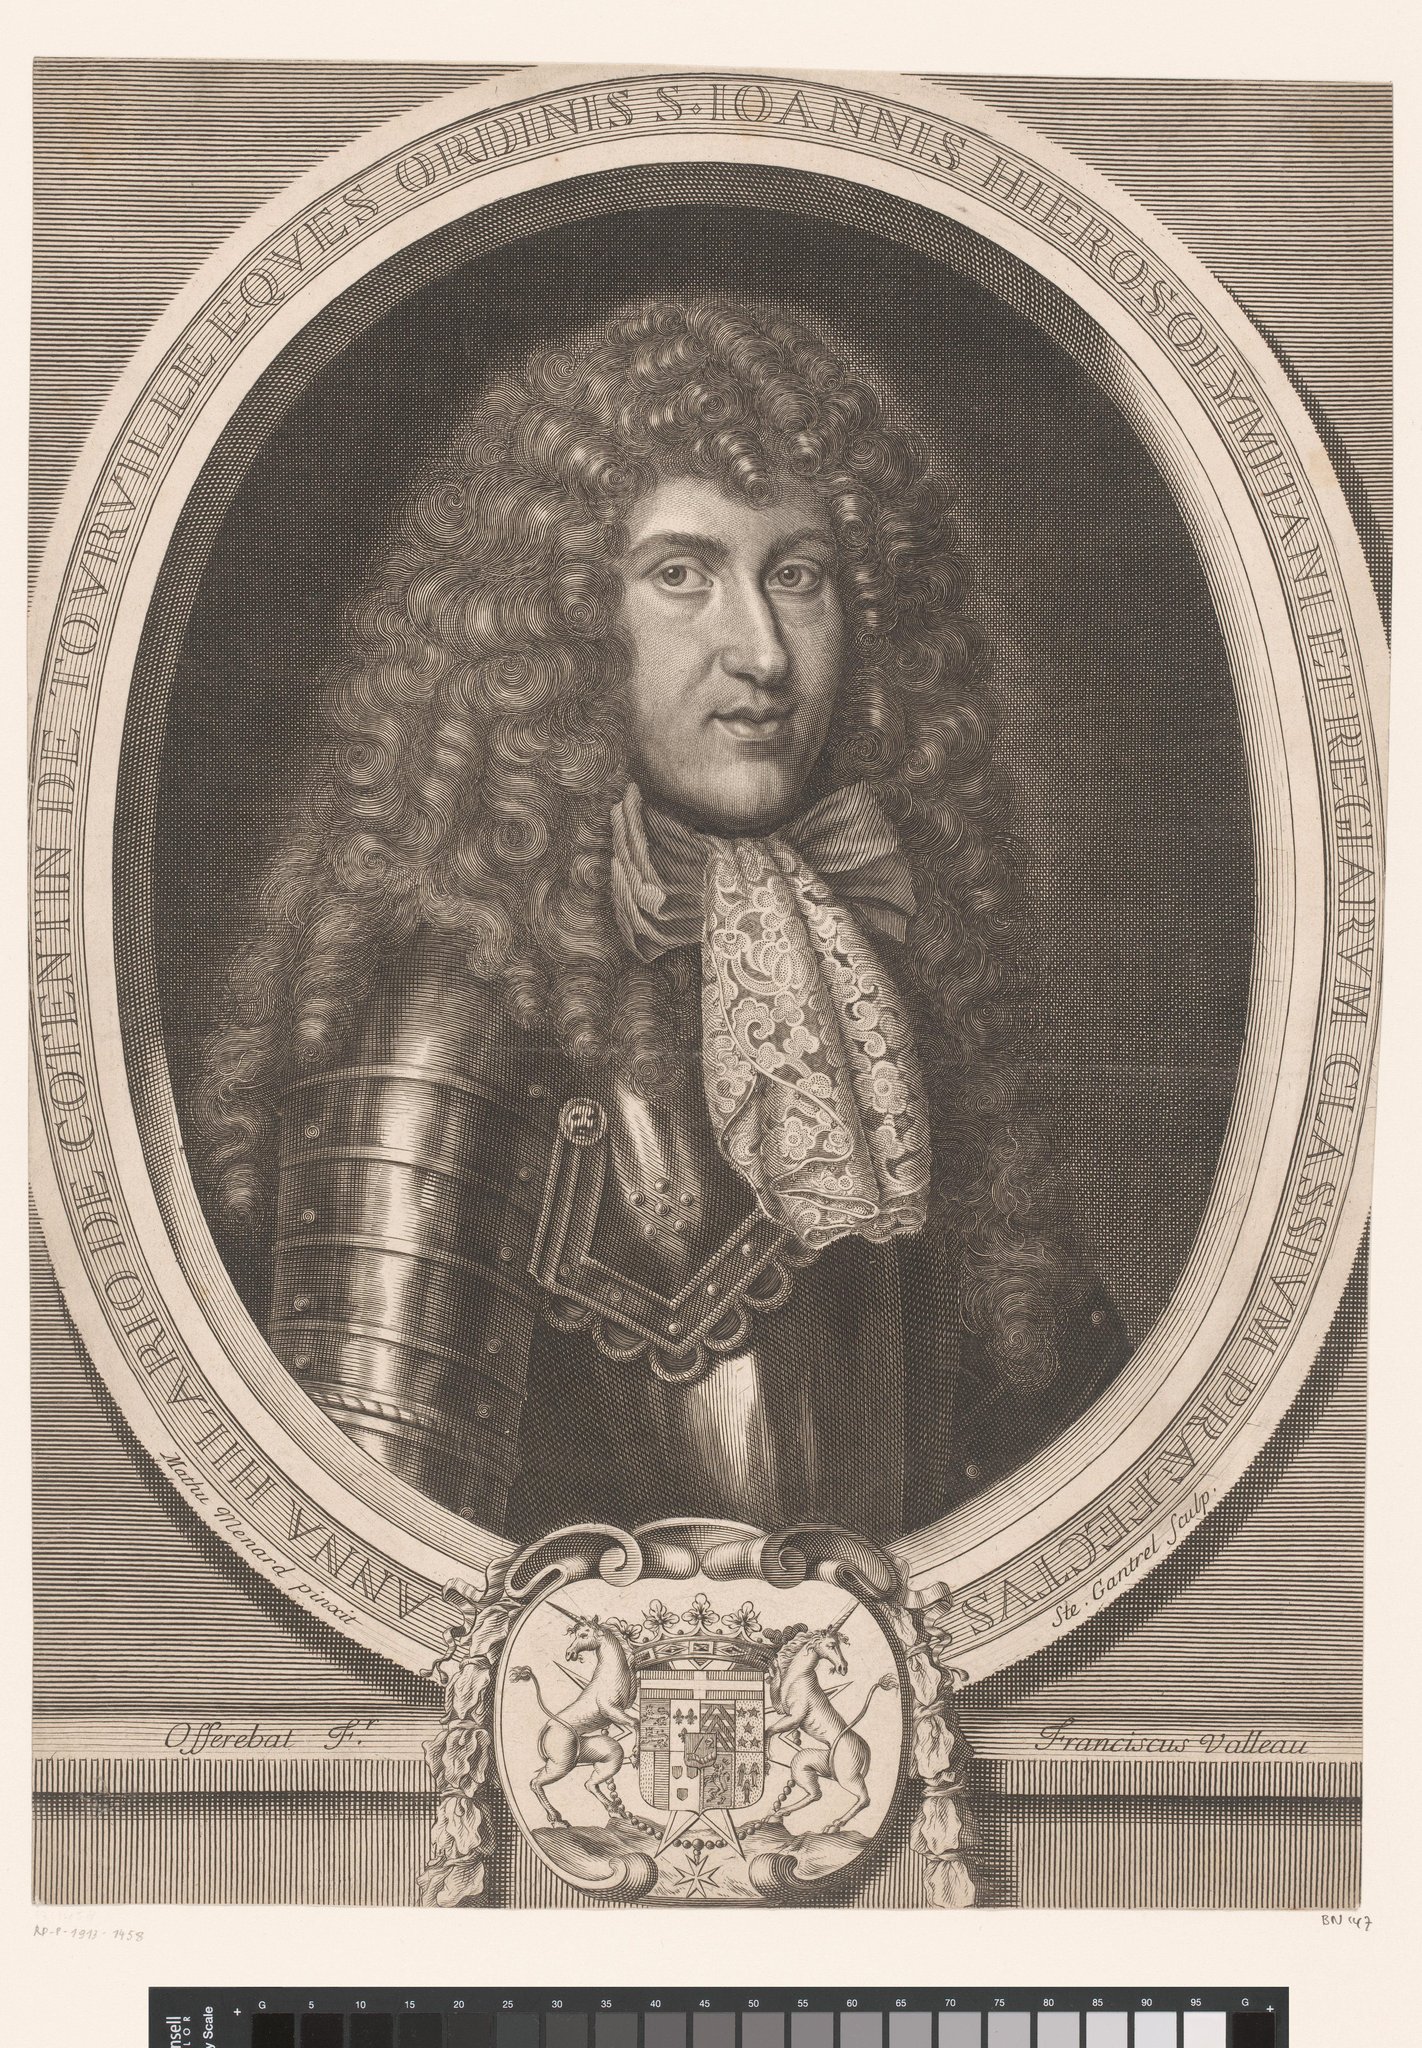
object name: print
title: Portret van Anne Hilarion de Tourville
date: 1656-1706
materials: paper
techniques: engraving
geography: france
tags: paris, unicorn, ornament ~ medallion, historical persons, armorial bearing, heraldry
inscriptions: collector's mark: Lugt 2228